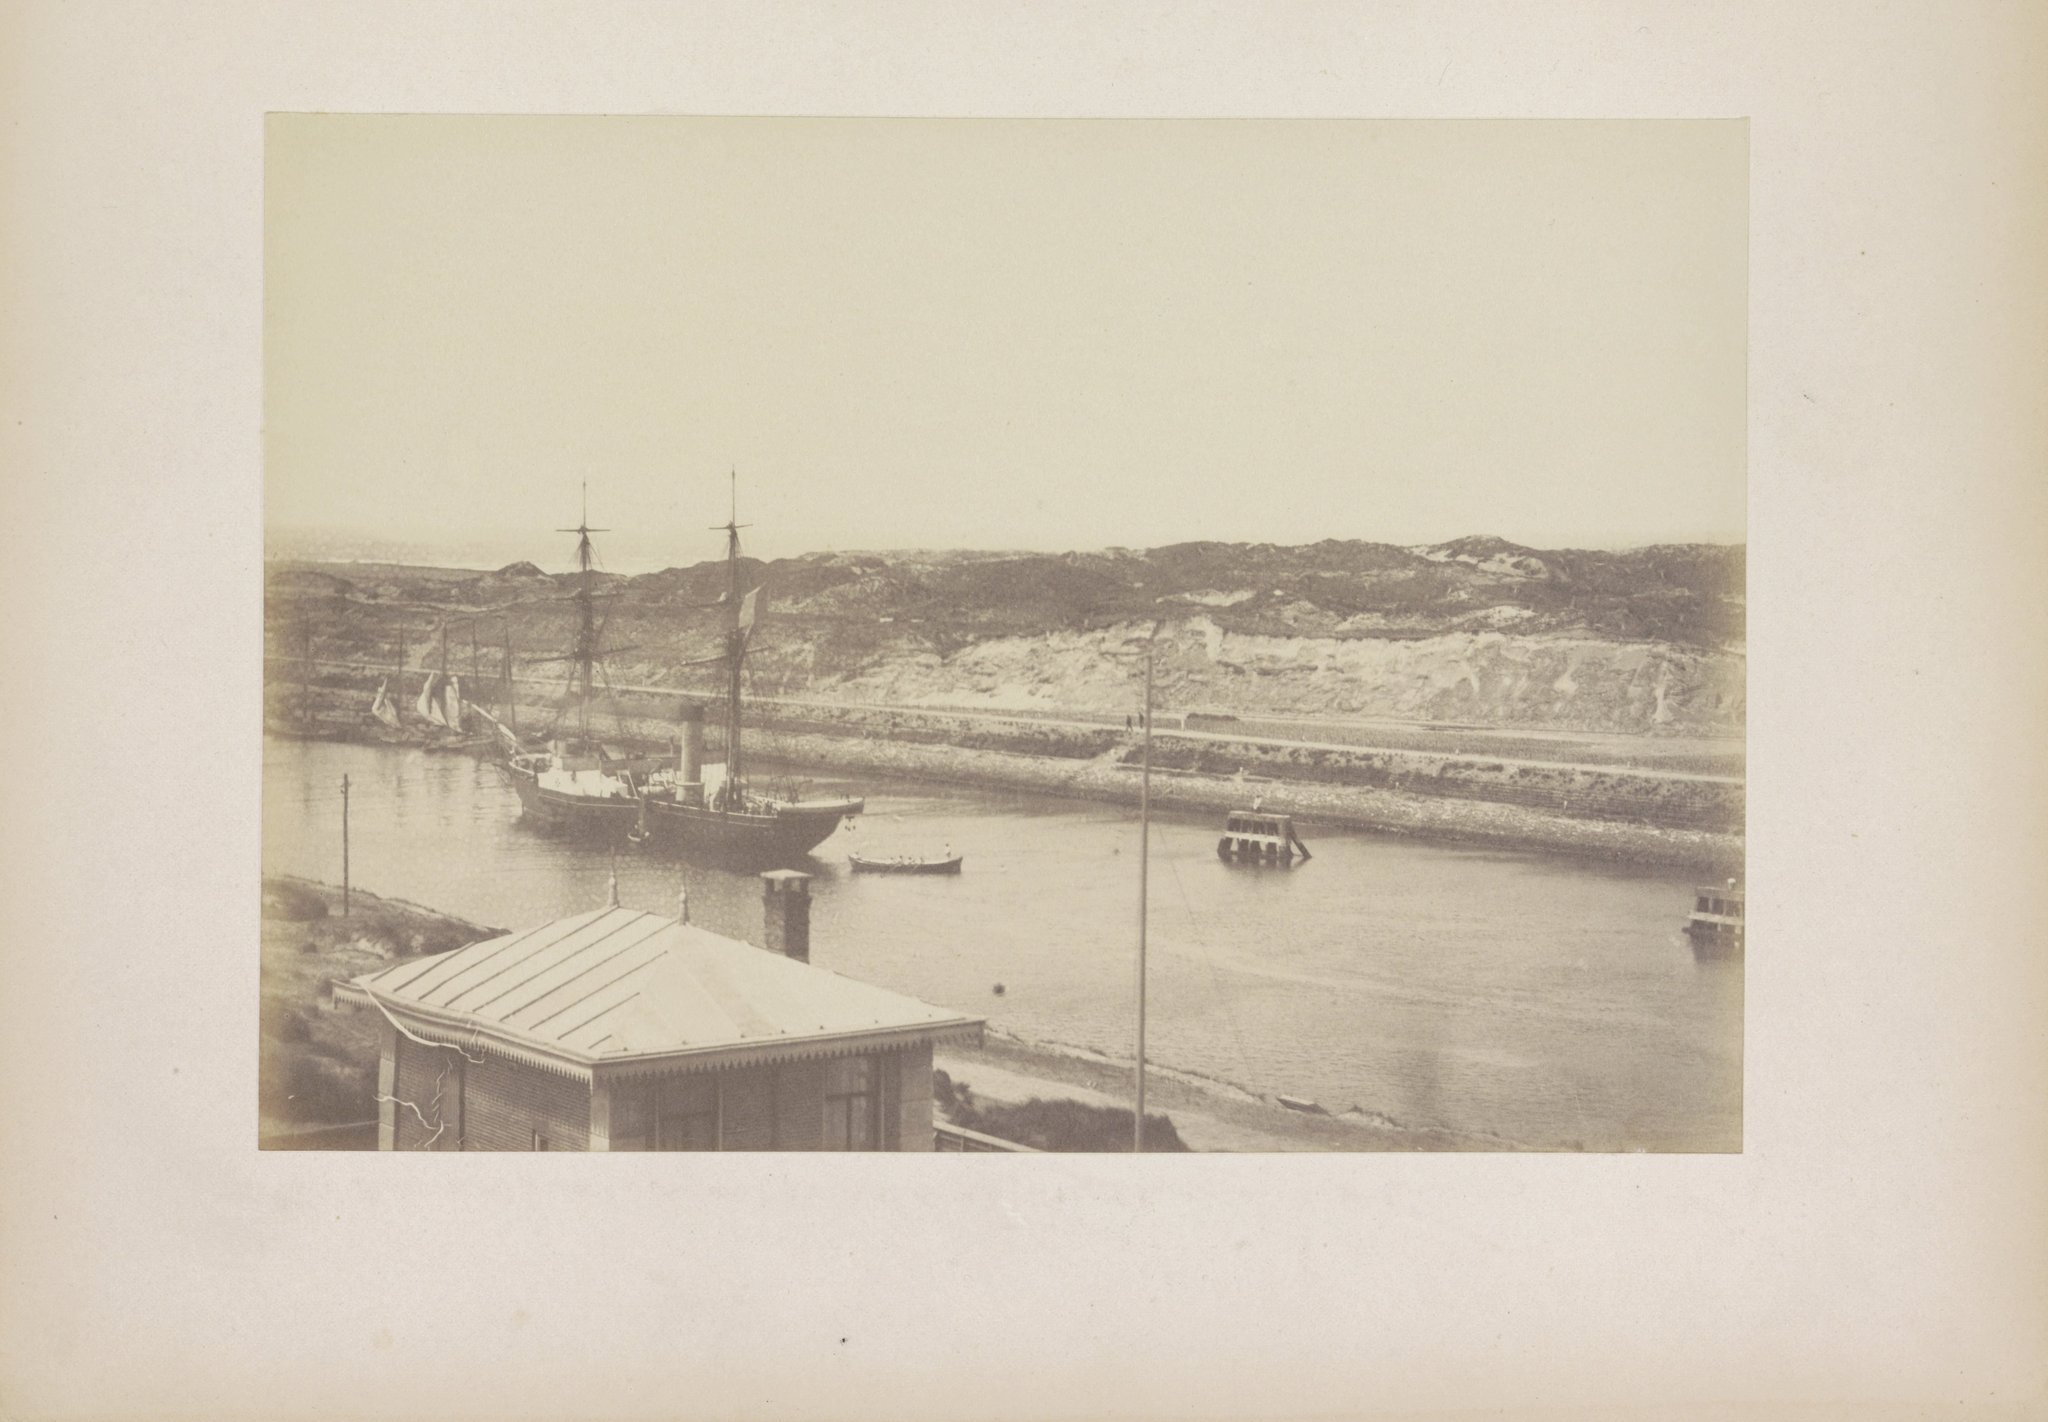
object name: photograph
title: De haven van IJmuiden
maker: Anonymous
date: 1885-1900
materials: paper, photographic support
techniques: albumen print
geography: ijmuiden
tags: harbour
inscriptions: annotation: ‘Hollande’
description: De haven van IJmuiden met links verschillende aangemeerde kleine schepen, Nederland. Een vrachtschip midden in het Noordzeekanaal. Op de achtergrond de duinen.